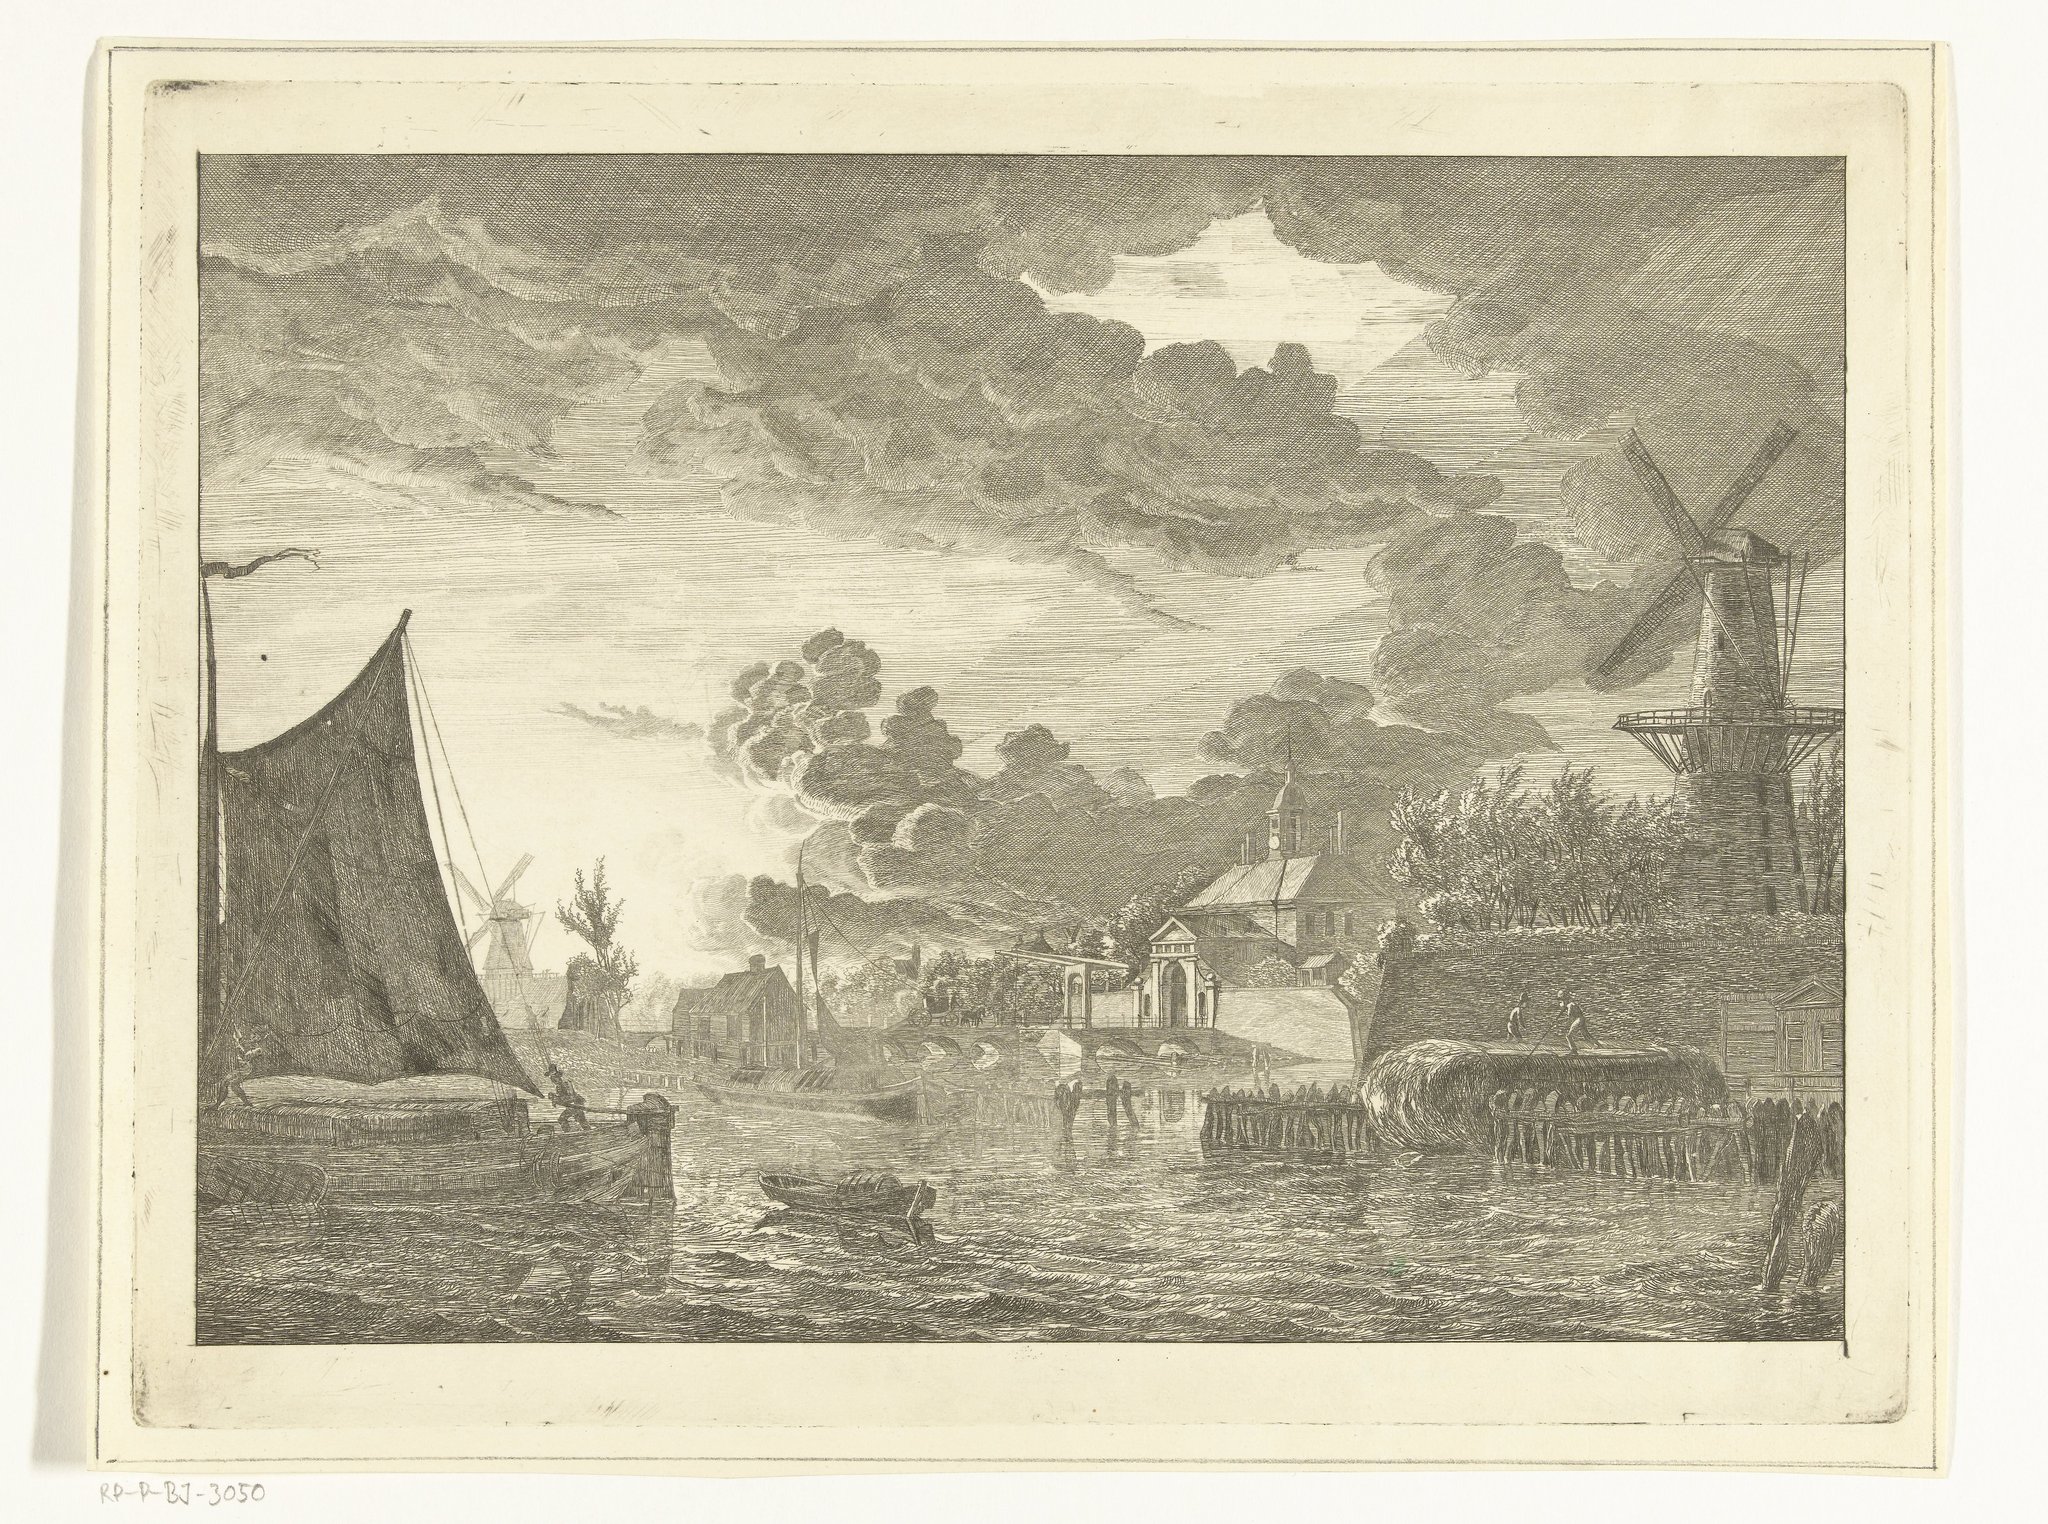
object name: print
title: Gezicht buiten de Utrechtse Poort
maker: johannes ludovicus van den bos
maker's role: draughtsman, print maker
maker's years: 1800-1827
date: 1815-1827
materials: paper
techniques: etching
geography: amsterdam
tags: utrechtsepoort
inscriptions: collector's mark: Lugt 2228